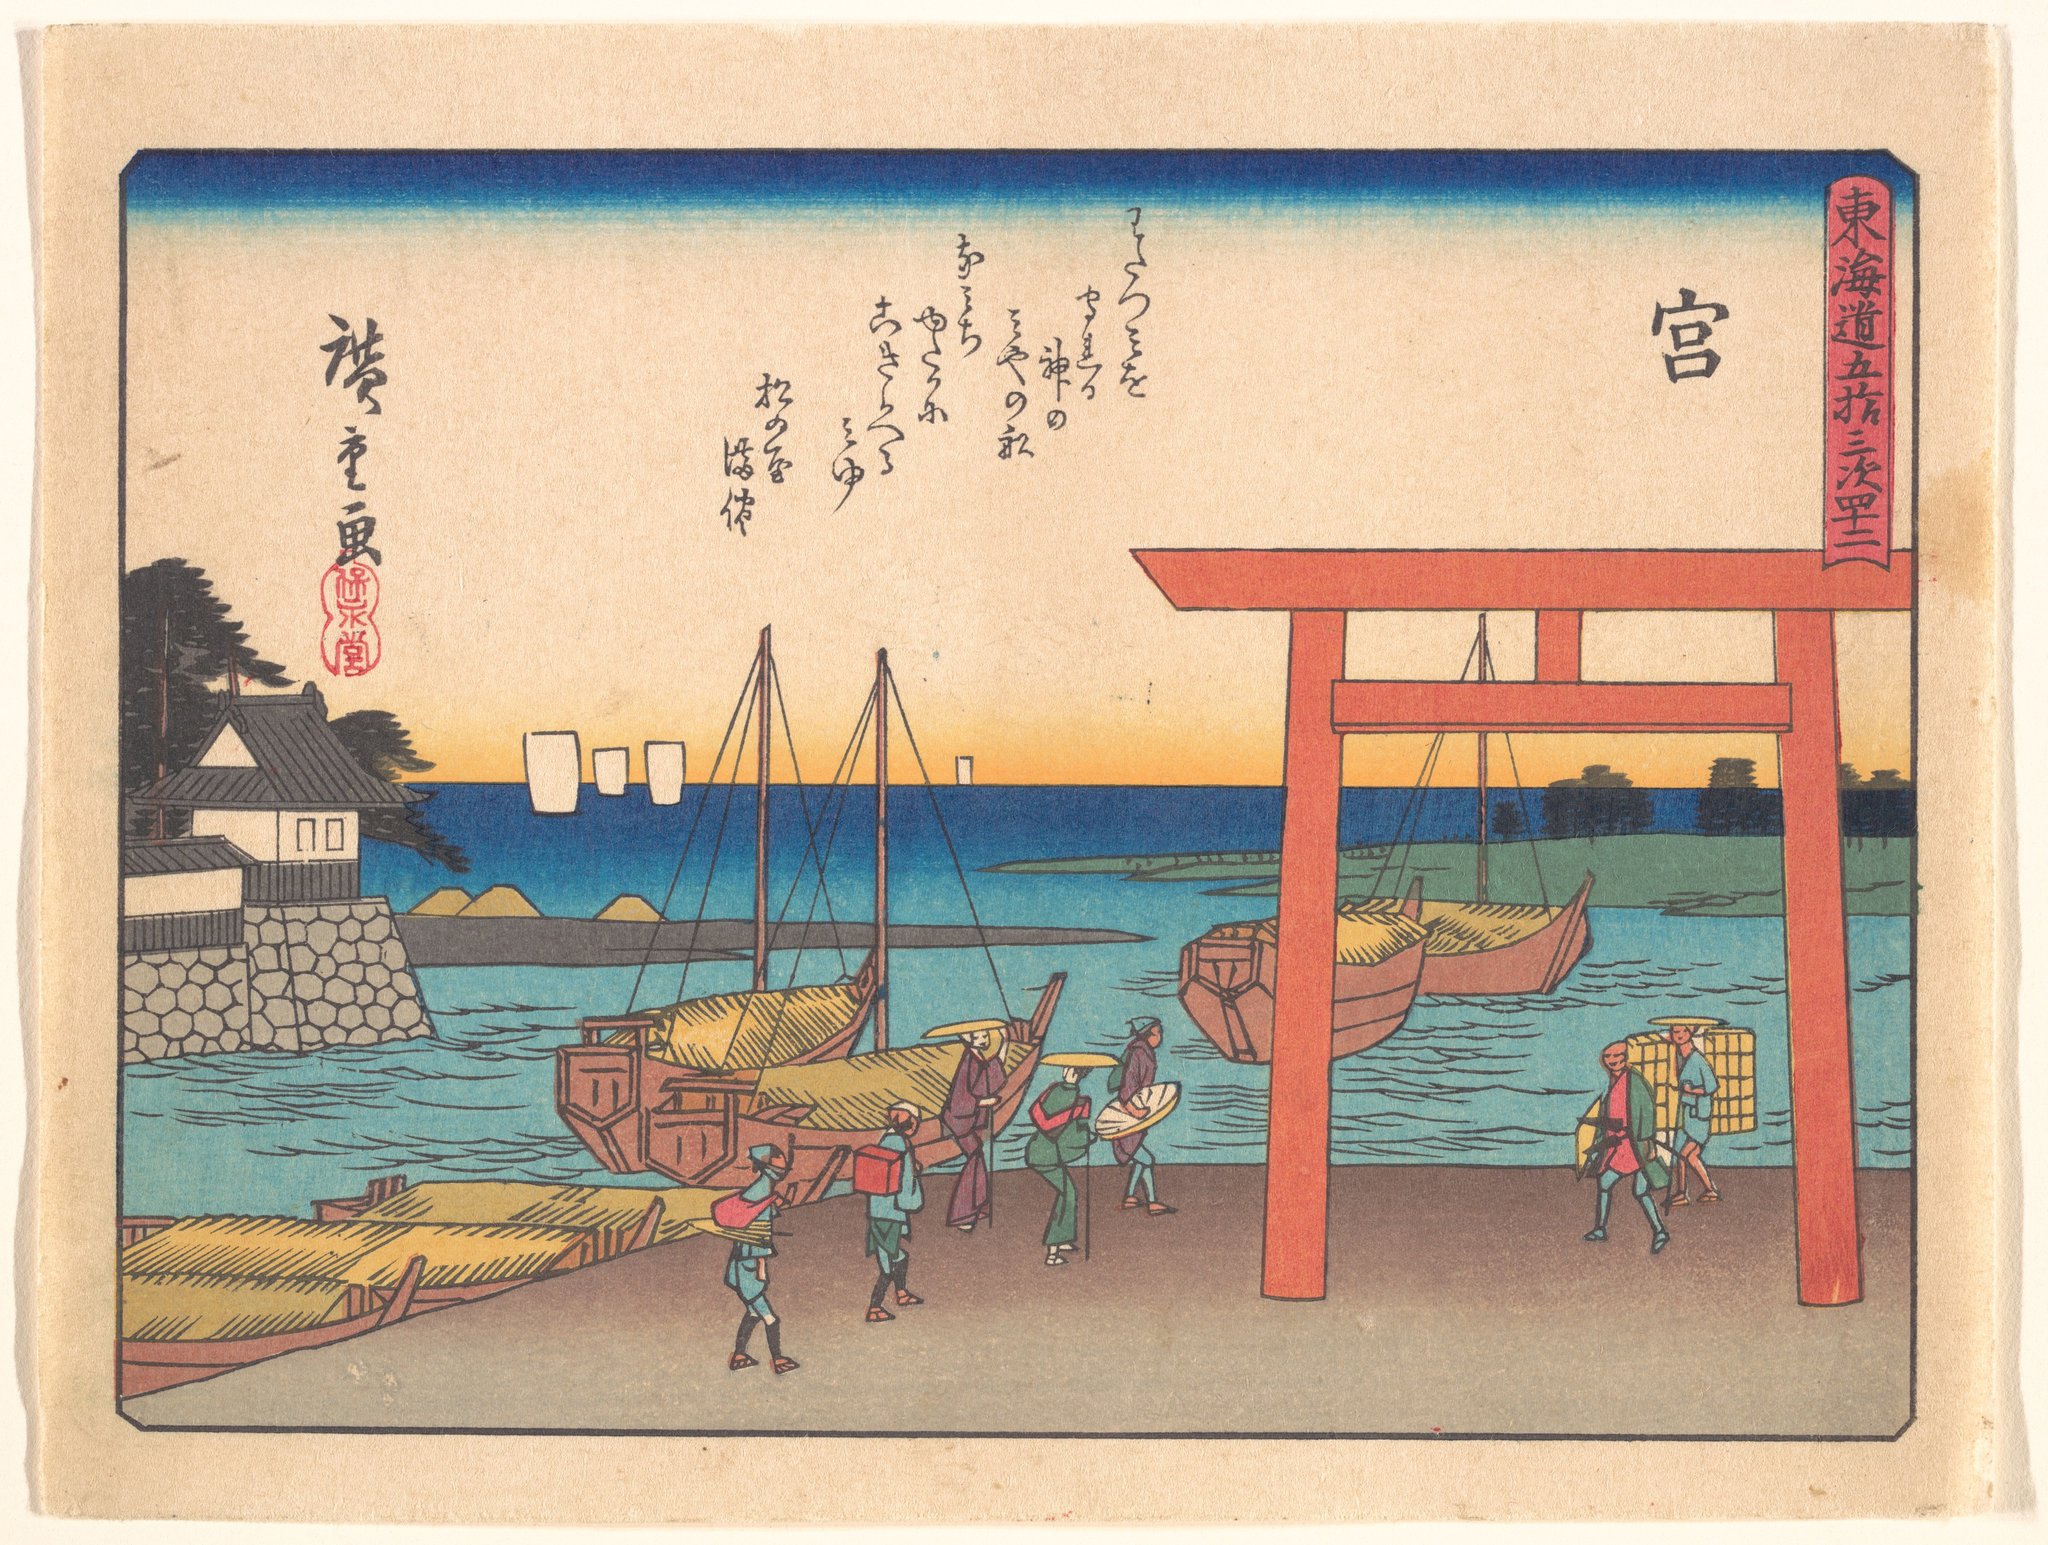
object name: print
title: Miya, from the series The Fifty-three Stations of the Tōkaidō Road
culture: japanese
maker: utagawa hiroshige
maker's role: artist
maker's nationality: japanese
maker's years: 1797-1858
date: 1901-1933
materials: ink, paper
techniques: woodblock print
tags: human figures,docks,gates,boats